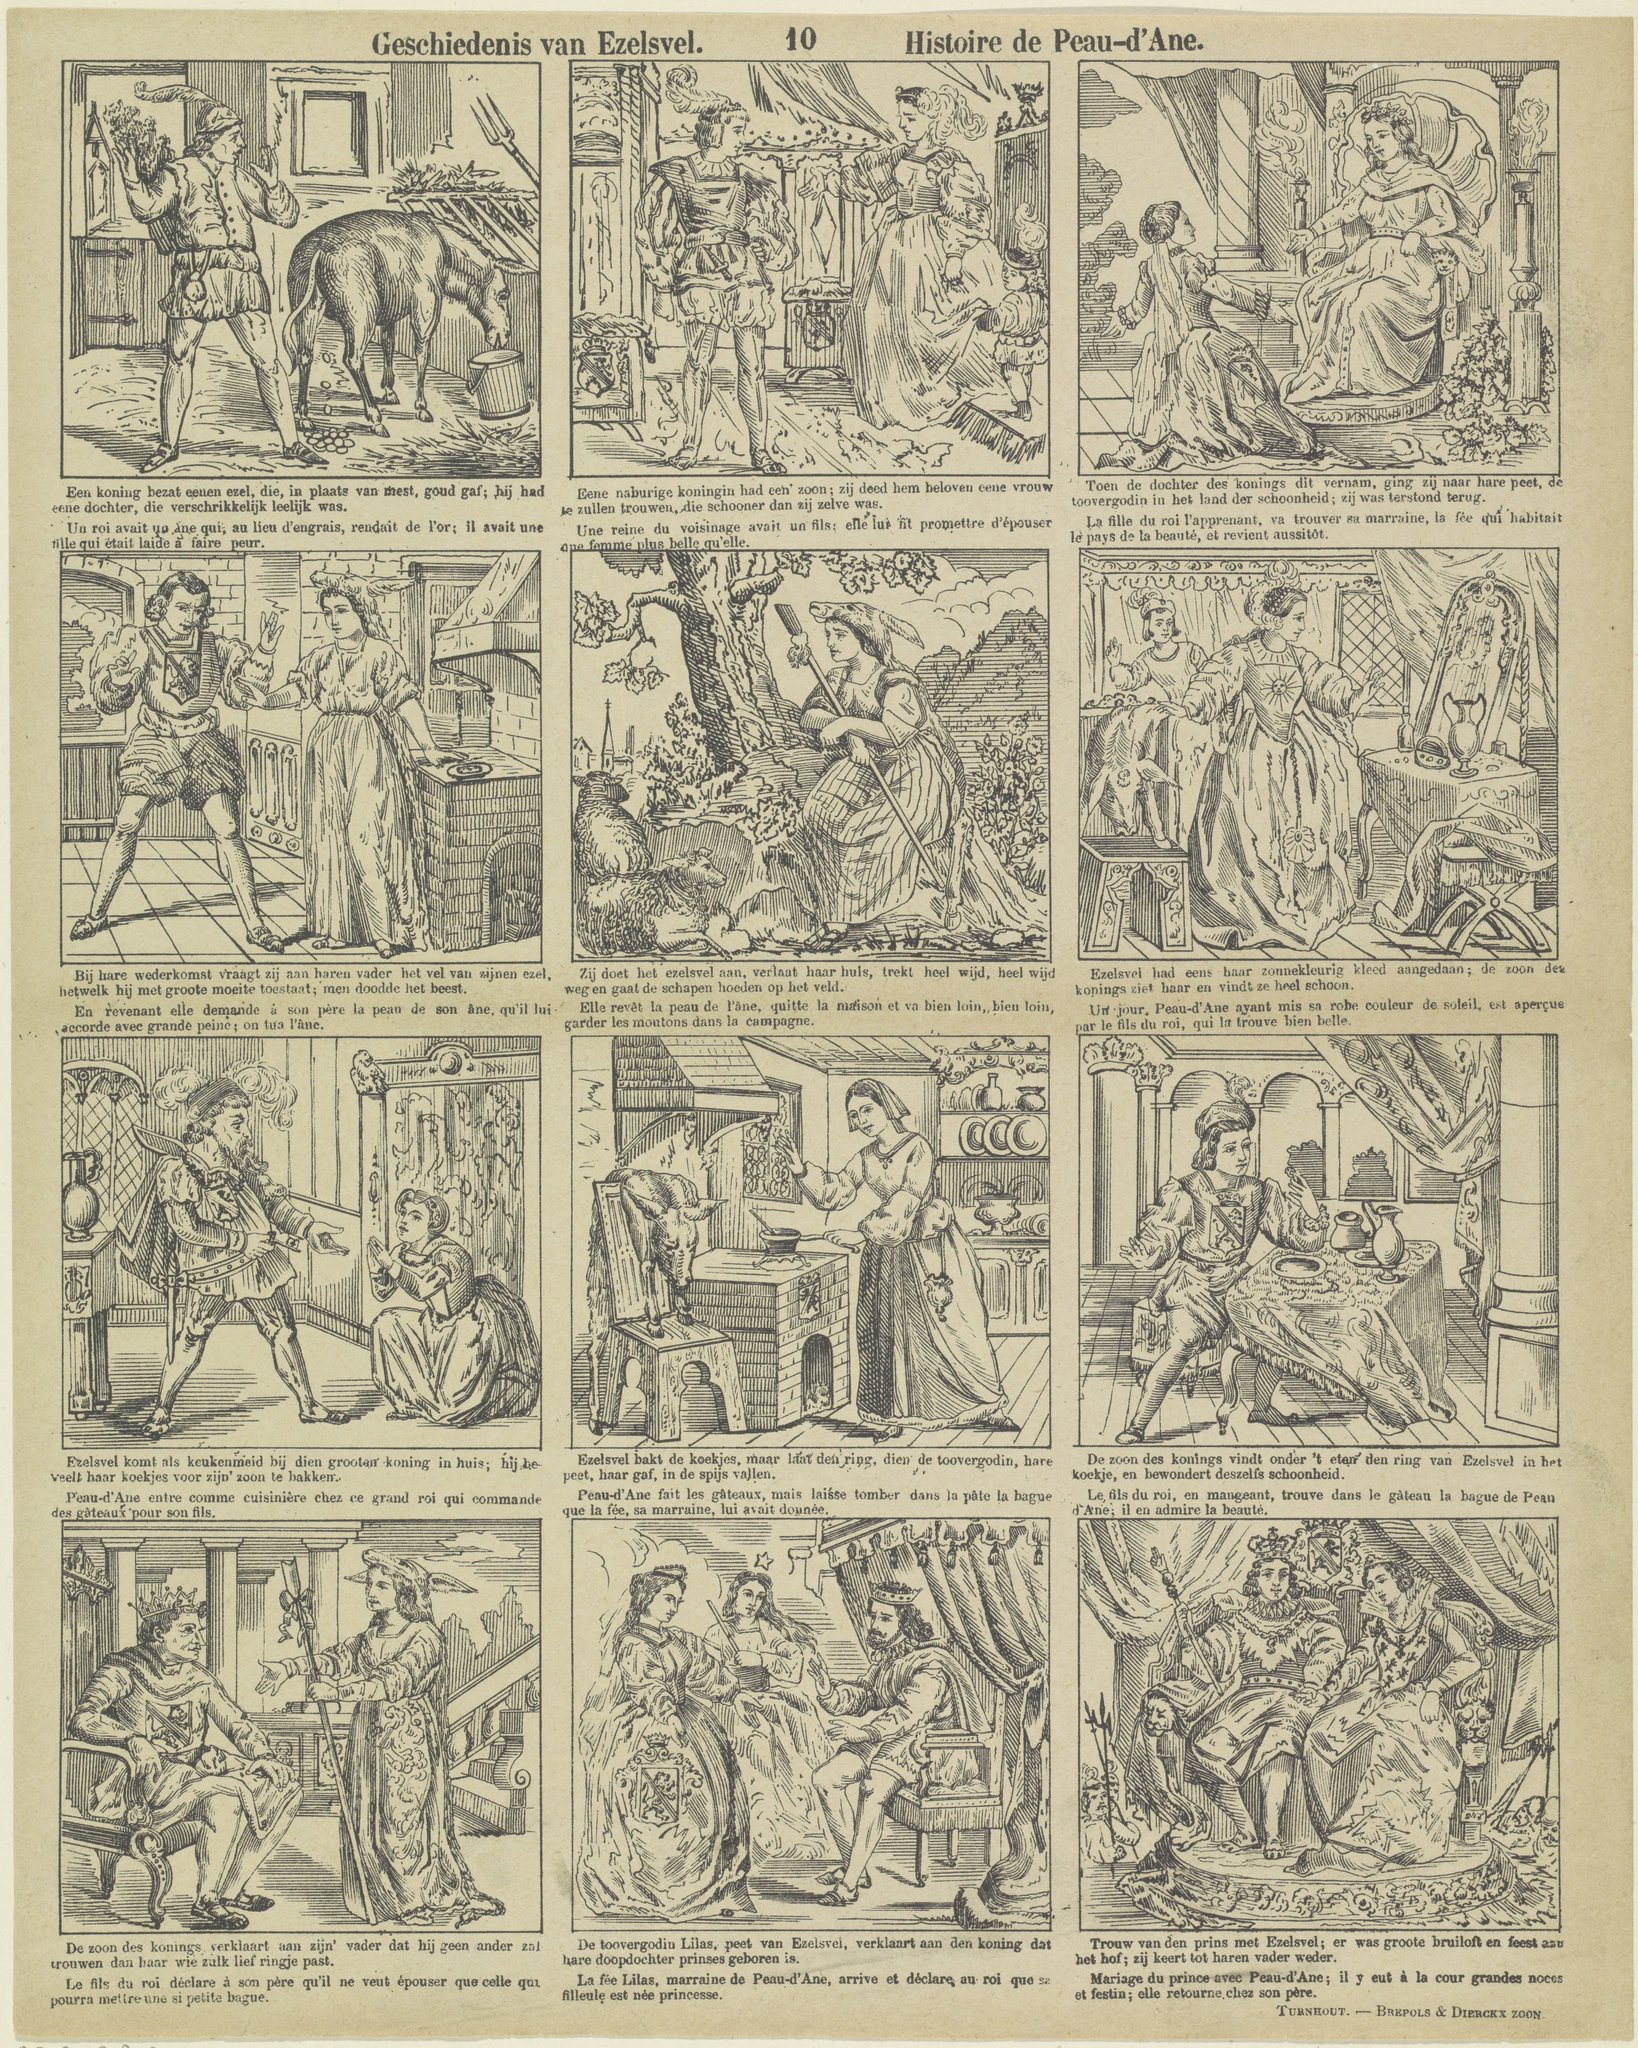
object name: print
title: Geschiedenis van Ezelsvel / Histoire de Peau-d'ane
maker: Anonymous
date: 1833-1911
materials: paper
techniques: letterpress printing, lithograph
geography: turnhout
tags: ass, donkey, tales and fairy tales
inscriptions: collector's mark: Lugt 2760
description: Blad met 12 voorstellingen uit het sprookje van Ezelsvel. Onder elke afbeelding een tweeregelig onderschrift in het Nederlands en in het Frans. Genummerd midden boven: 10.